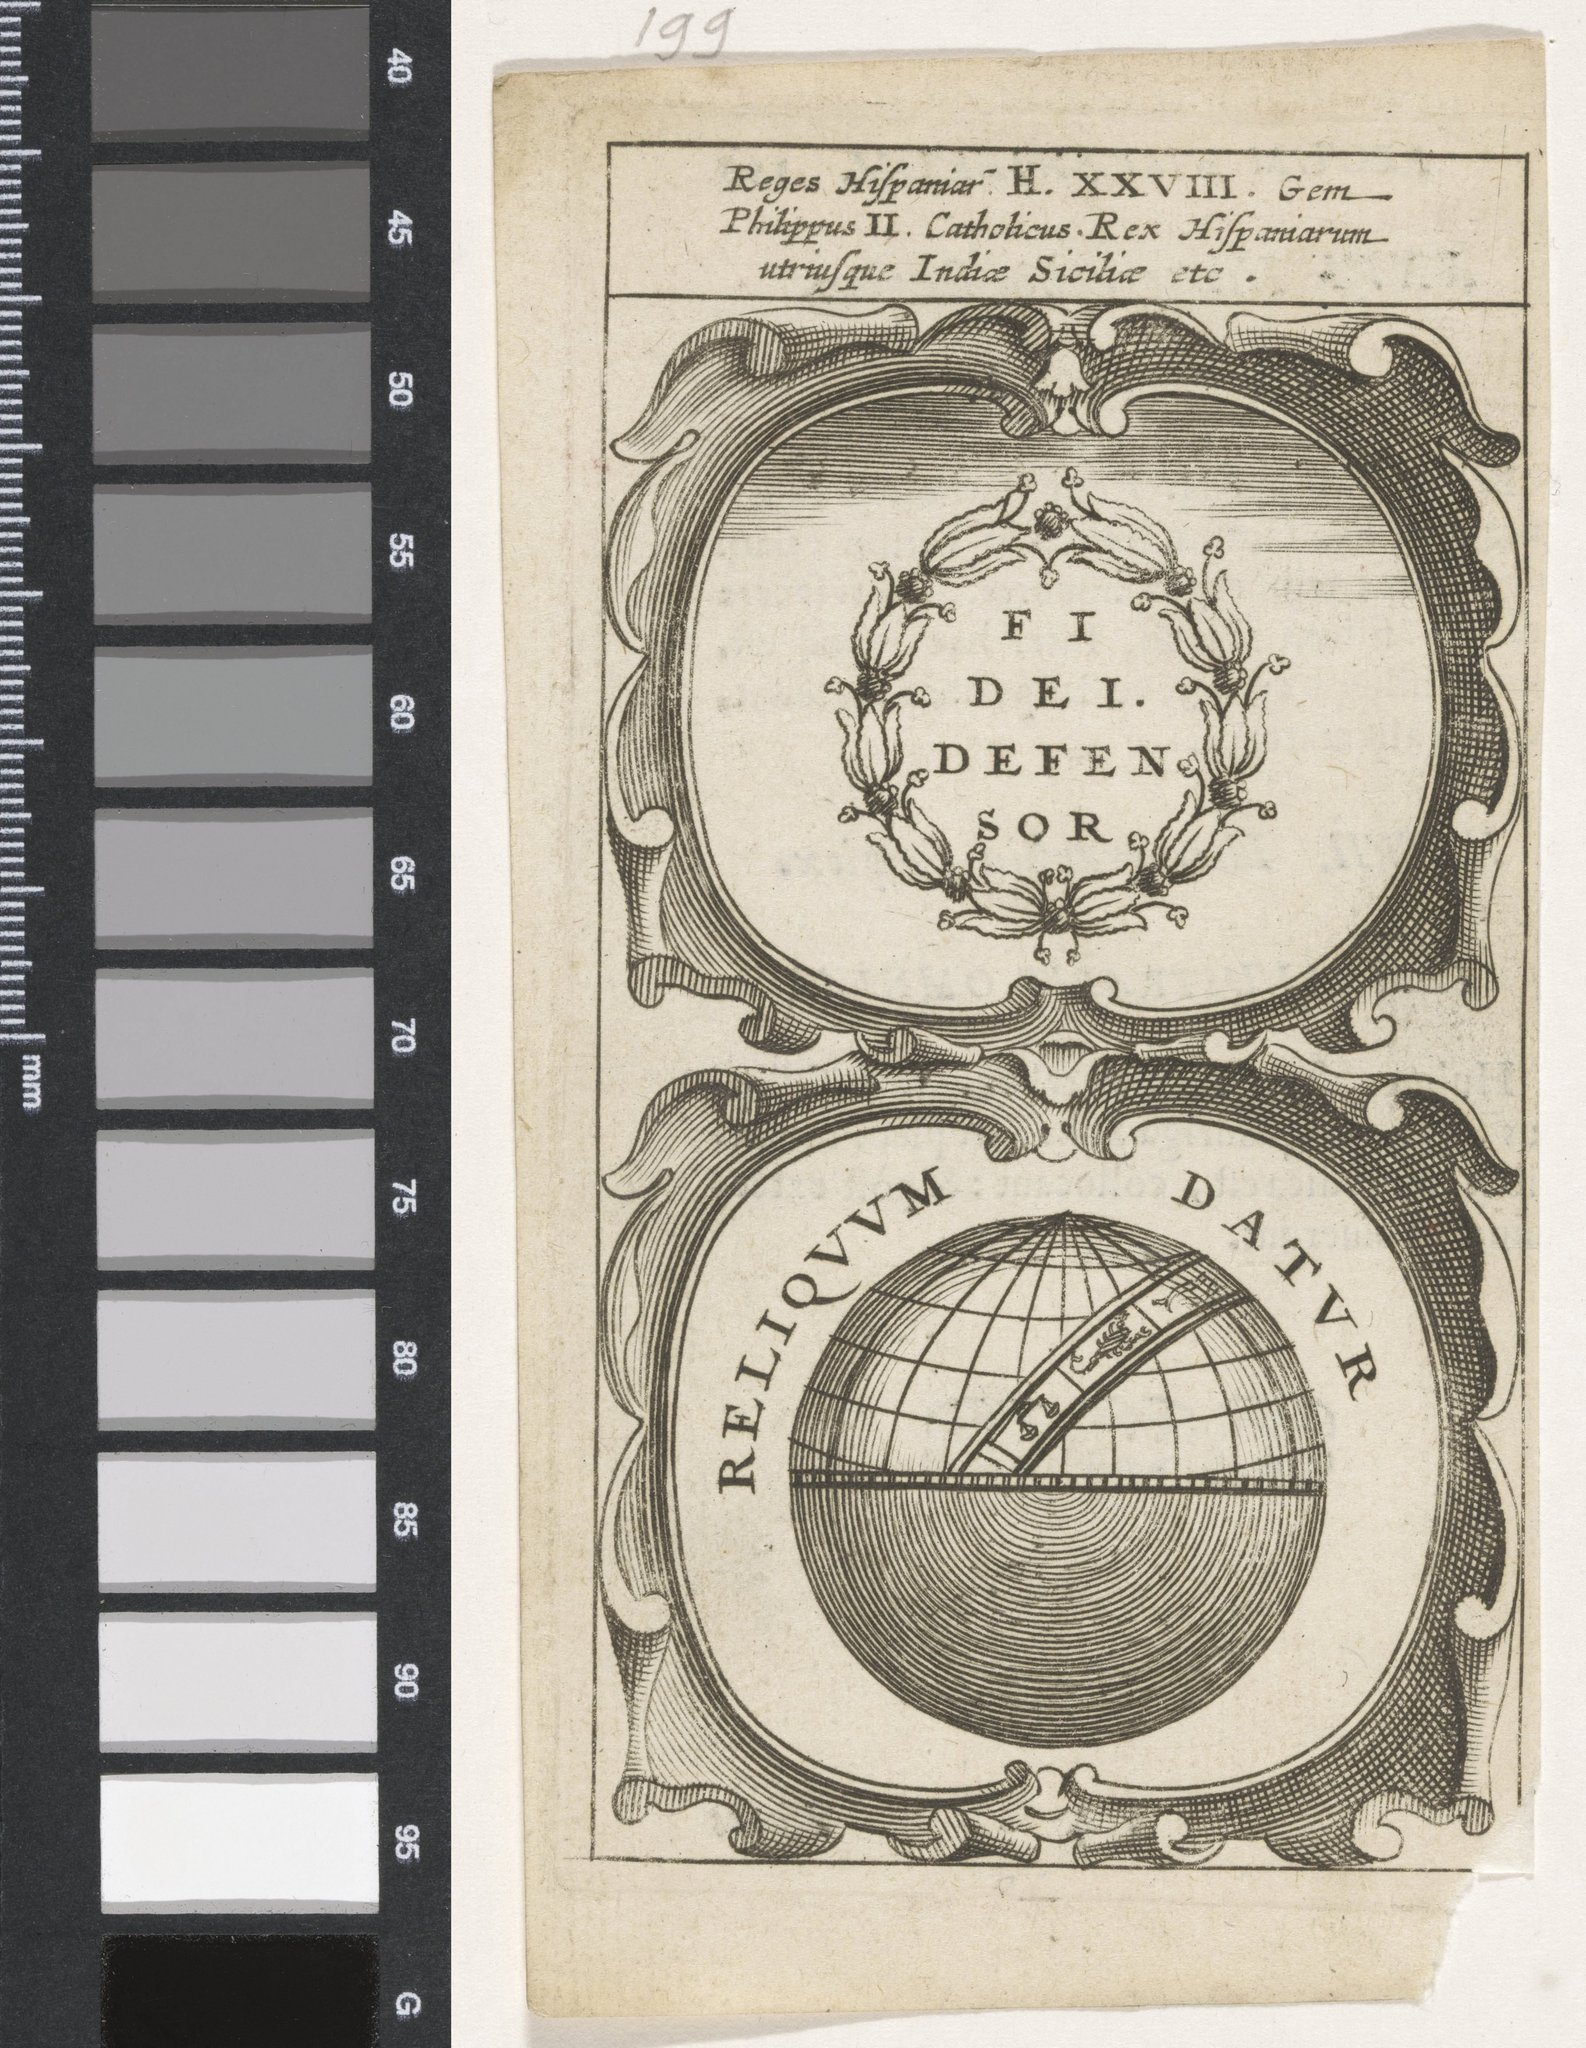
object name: print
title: Symbola Divina et Humana Pontificum Imperatorum Regum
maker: Anonymous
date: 1666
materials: paper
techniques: engraving, letterpress printing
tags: philip ii of spain, earth, world as celestial body, garland, wreath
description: Pagina uit Jacob Typotius, Symbola Divina & Humana Pontificum Imperatorum Regum. Arnhem, J.F. Hagen, 1666 of uit de titeluitgave van 1669 of 1679. Het werk van Typotius werd voor het eerst uitgegeven in 1601 met prenten van Aegidius Sadeler.